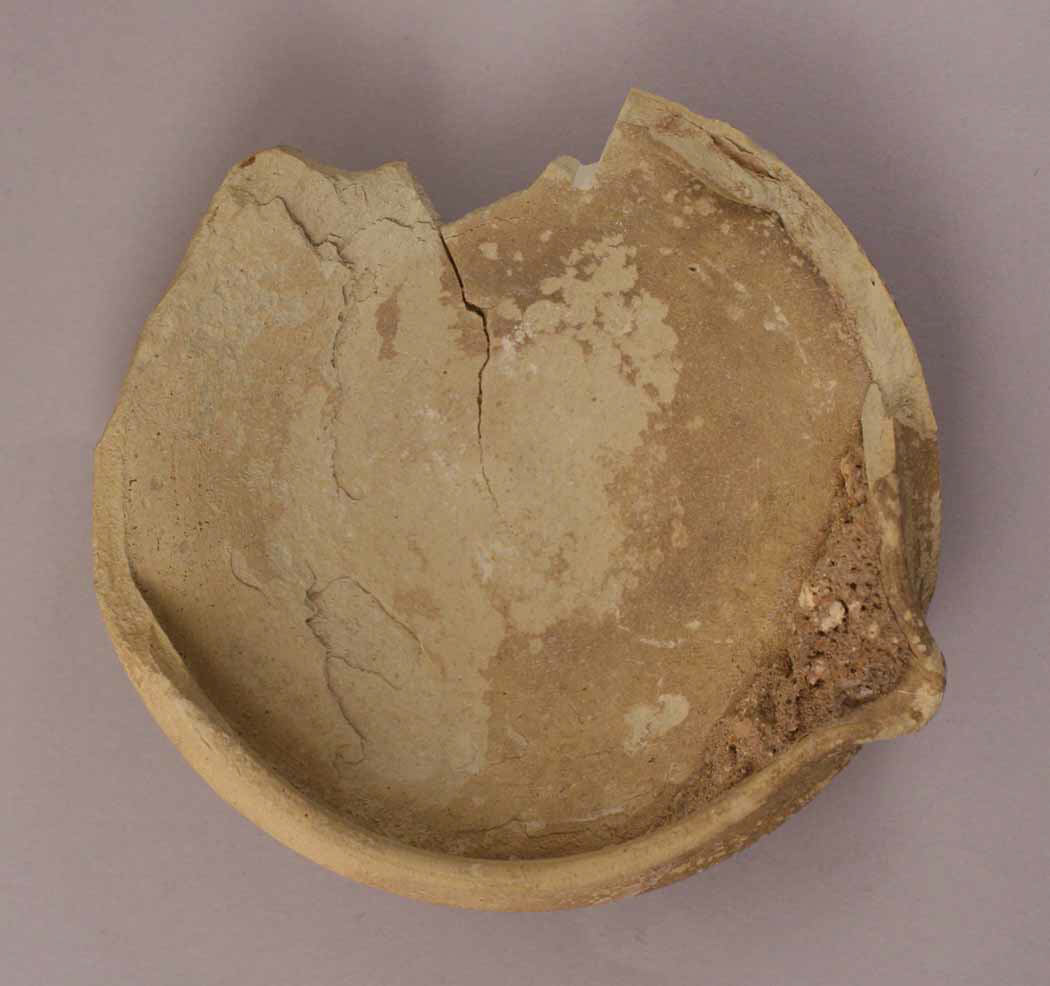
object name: lamp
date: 801-900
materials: earthenware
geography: iraq